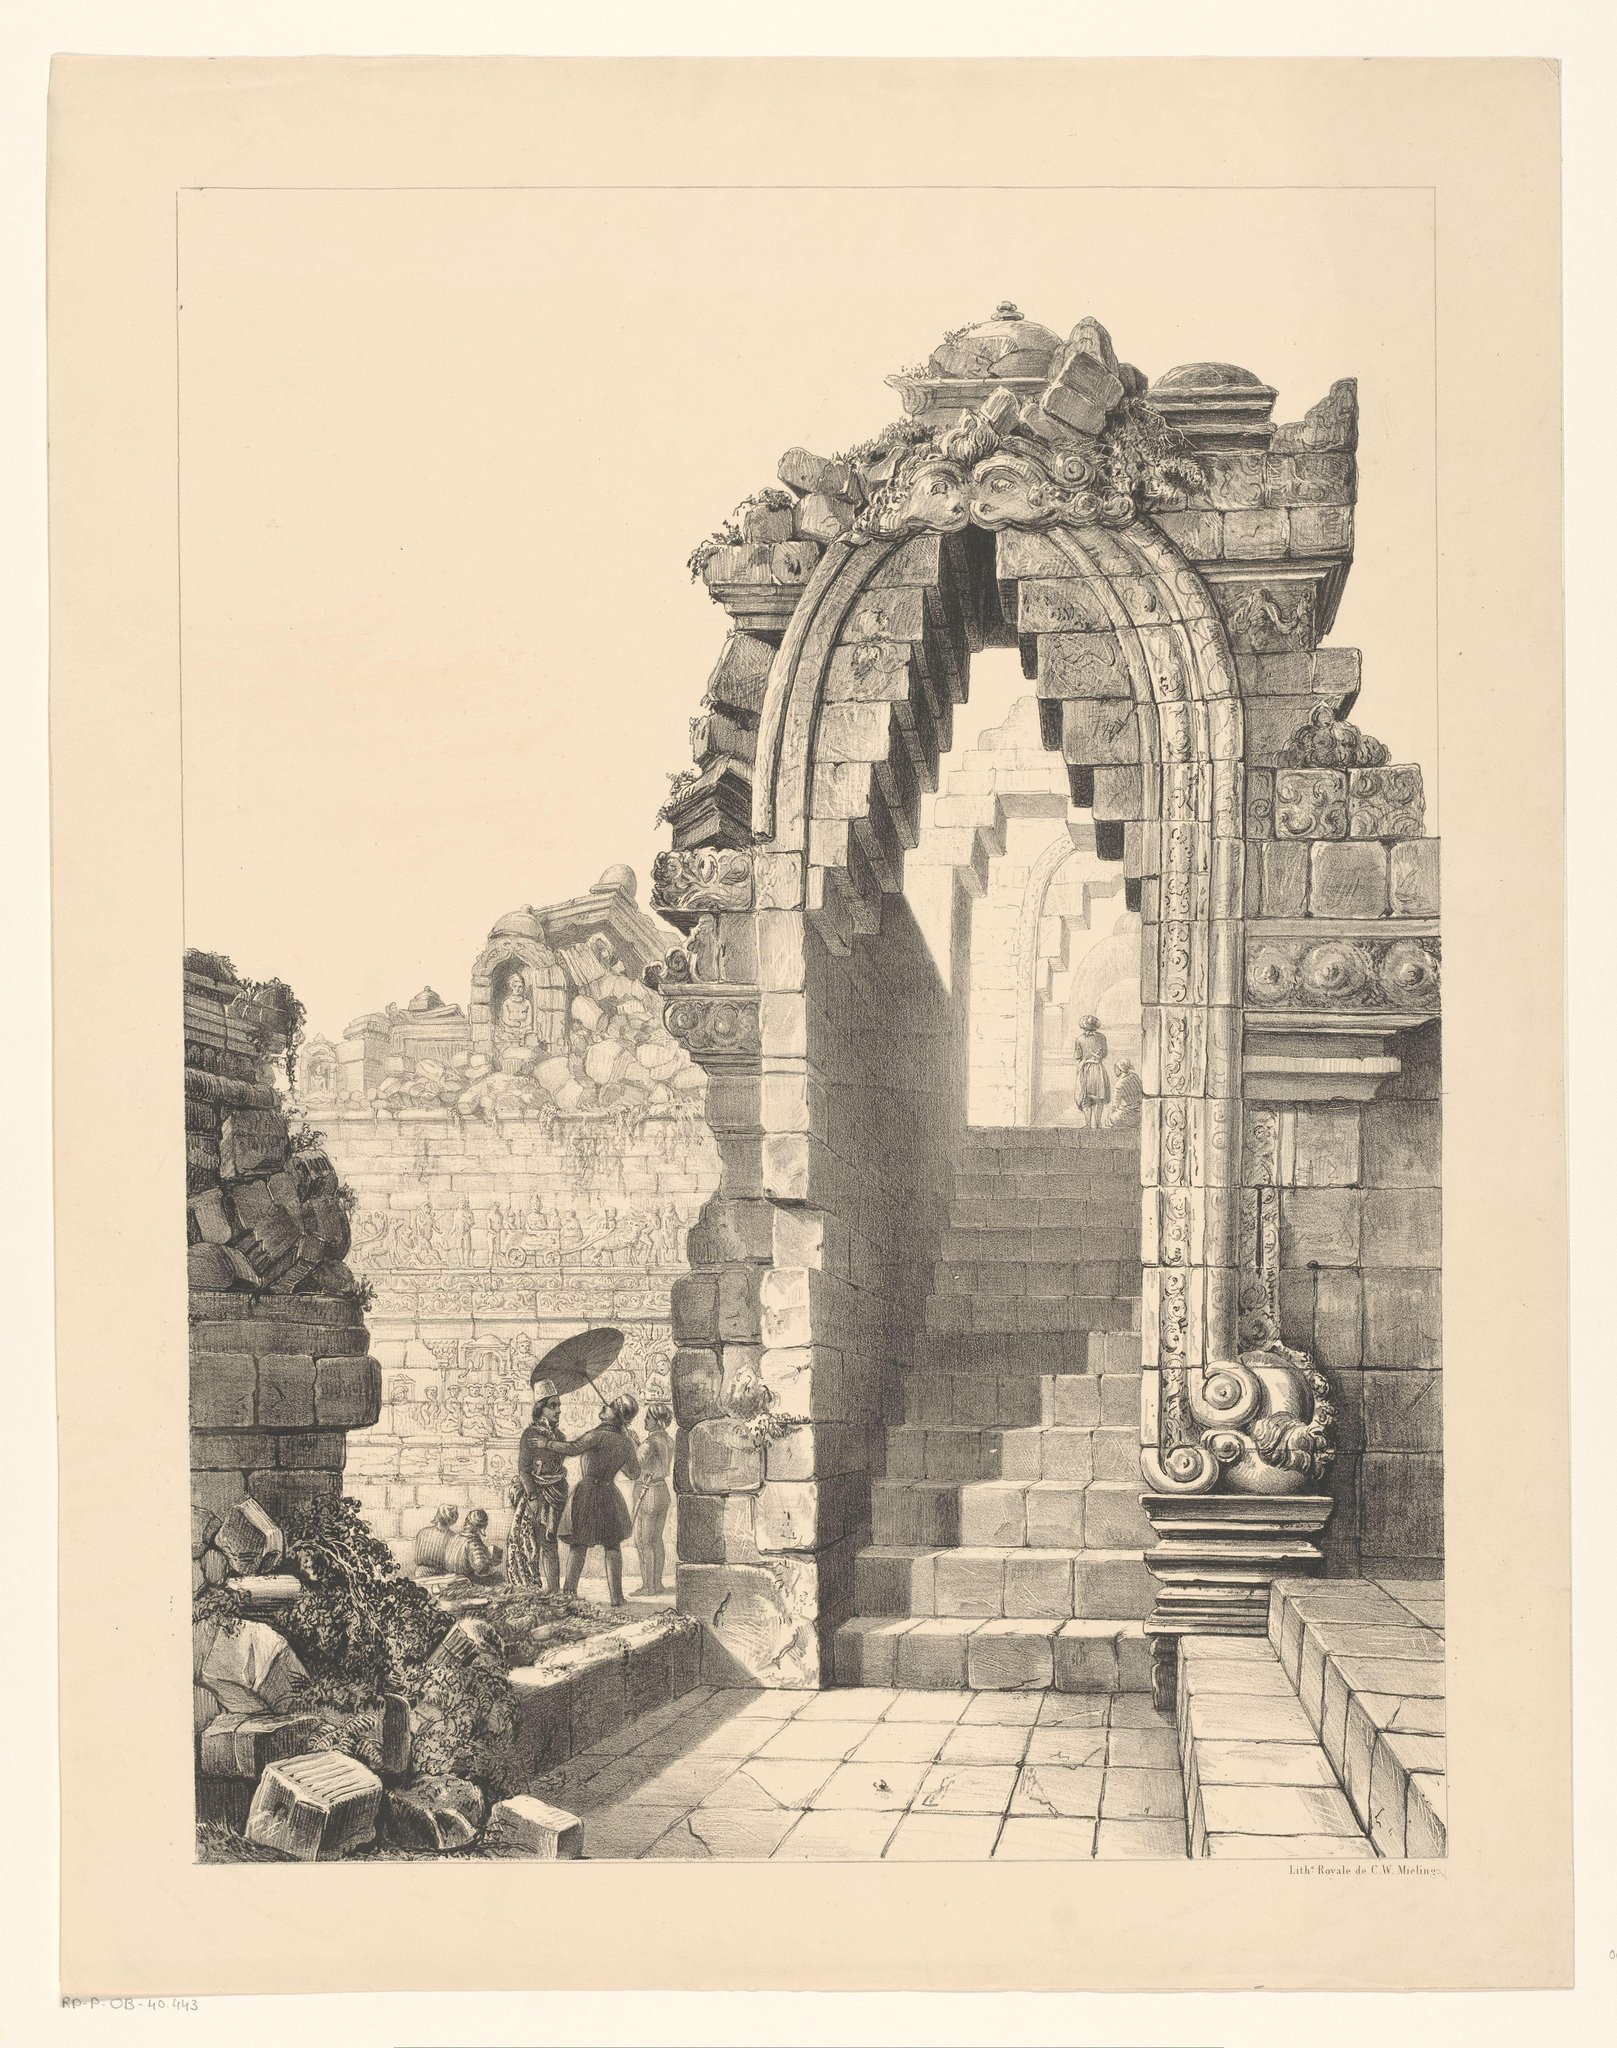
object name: print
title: Boro Boedo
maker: cornelis springer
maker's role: draughtsman, painter, print maker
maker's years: 1817-1891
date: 1852-1856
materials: paper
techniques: lithograph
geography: the hague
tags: temple, shrine ~ hinduism, buddhism, jainism, ruin of a building ~ architecture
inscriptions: collector's mark: Lugt 2228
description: Ruïne van het heiligdom Borobudur bij Jogyakarta. Tussen de ruïnes lopen enkele figuren. Centraal staat een trap, overdekt met een spitsboog. Links wordt een edelman door een bediende beschermt tegen de zon met een parasol.